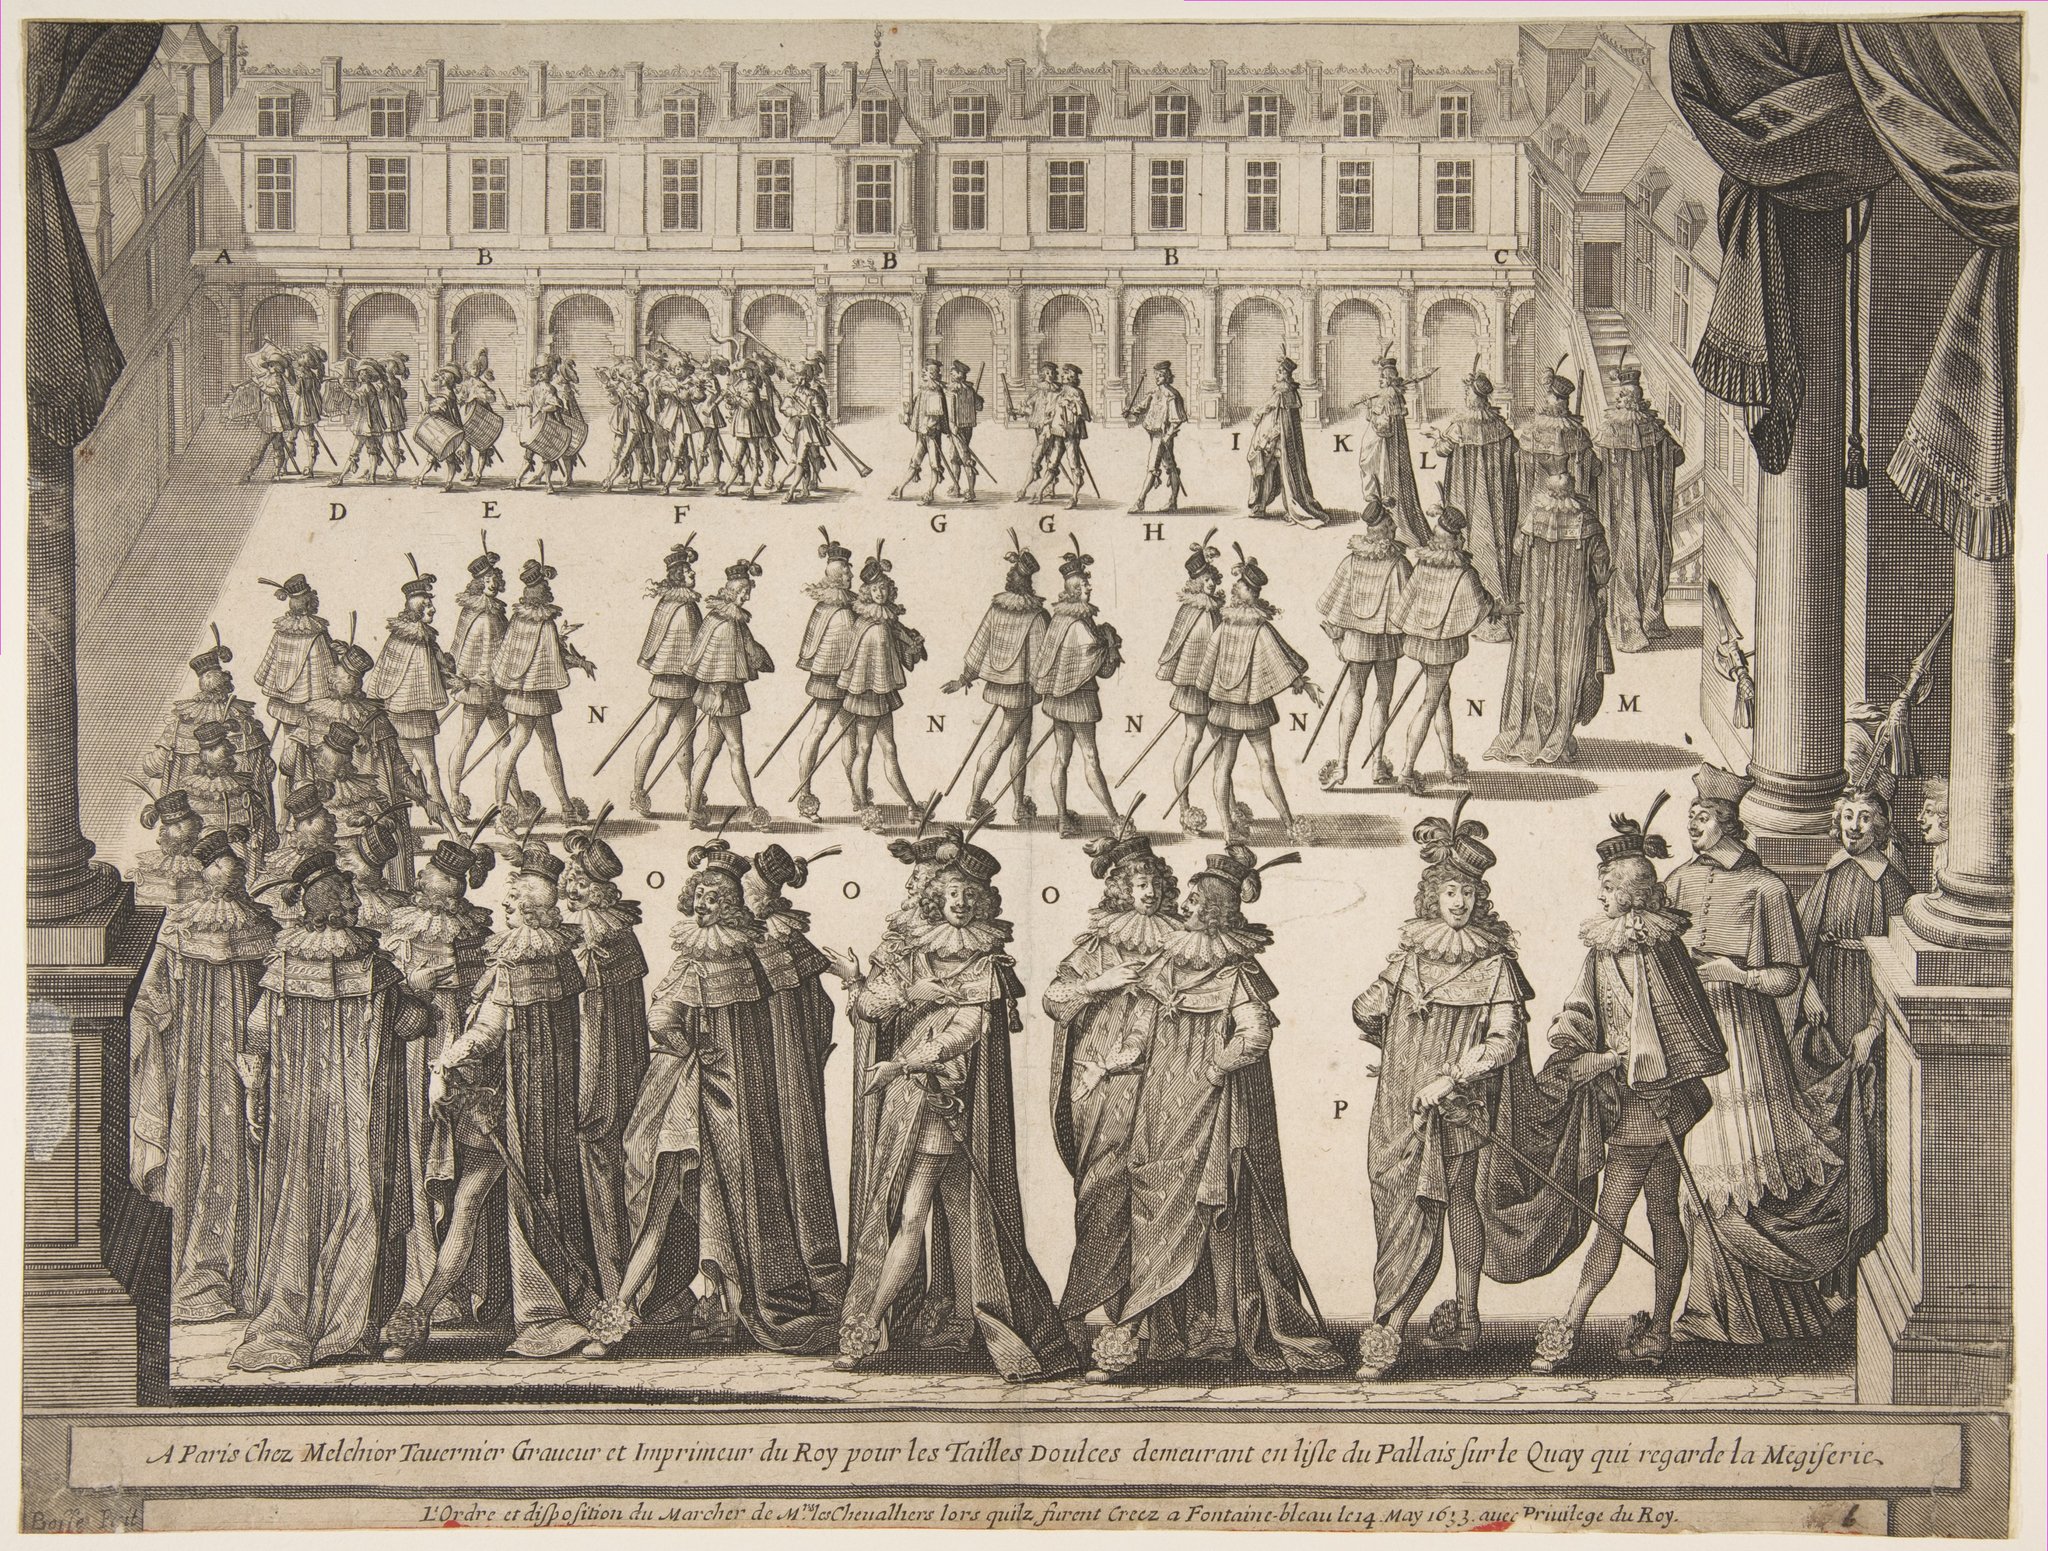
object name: print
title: Order of the Chevaliers Marching at Fontainebleau in May 1633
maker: abraham bosse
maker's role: artist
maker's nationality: french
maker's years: 1602-1676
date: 1634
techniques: etching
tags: buildings,knights